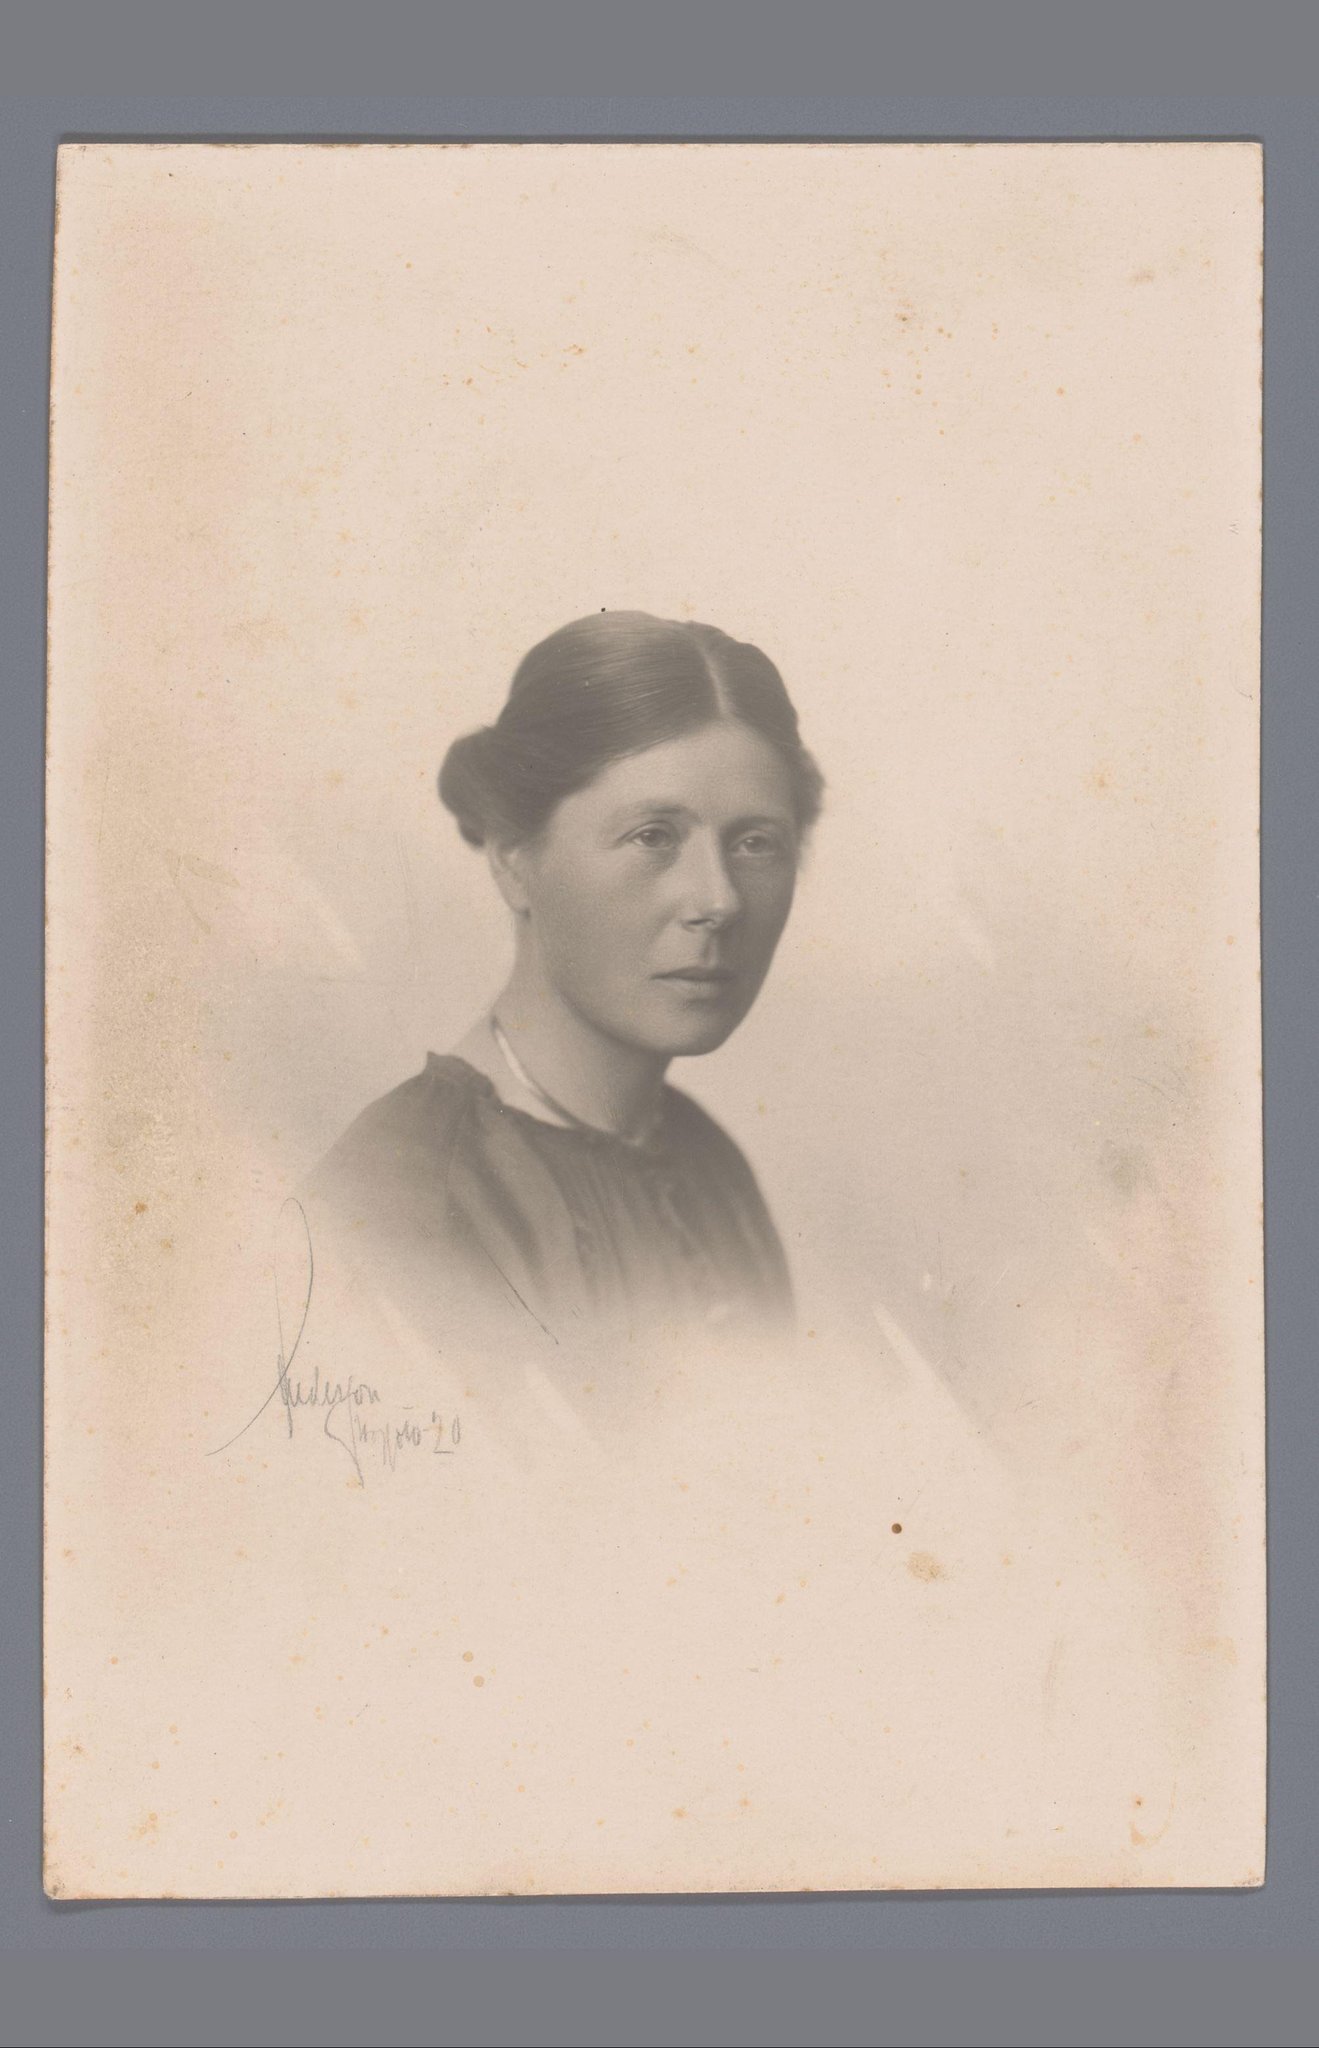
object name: photograph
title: Portret van een onbekende vrouw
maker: Anonymous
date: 1880-1920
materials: photographic support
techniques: collodion silver print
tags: historical persons - bb - woman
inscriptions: annotation: ‘[...] 20’